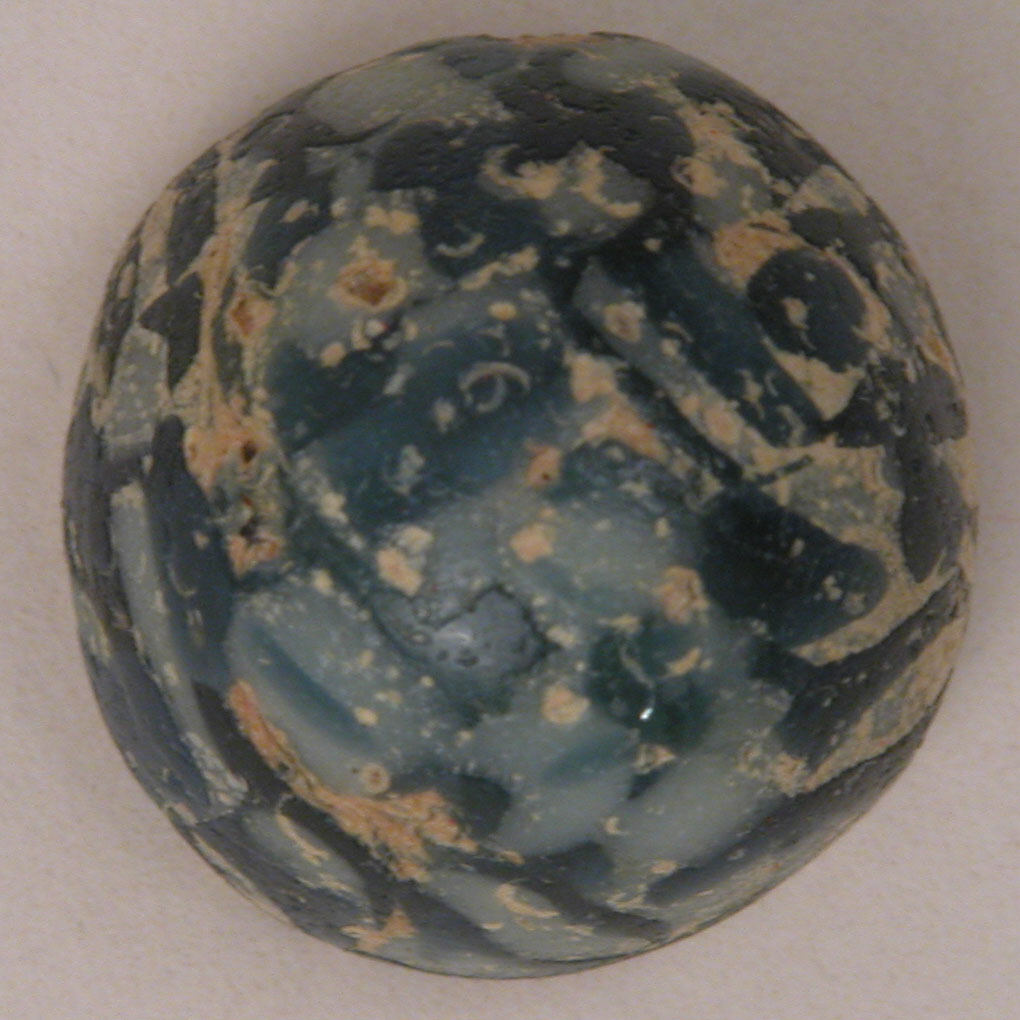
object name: gaming piece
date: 701-1200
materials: glass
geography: islamic lands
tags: games